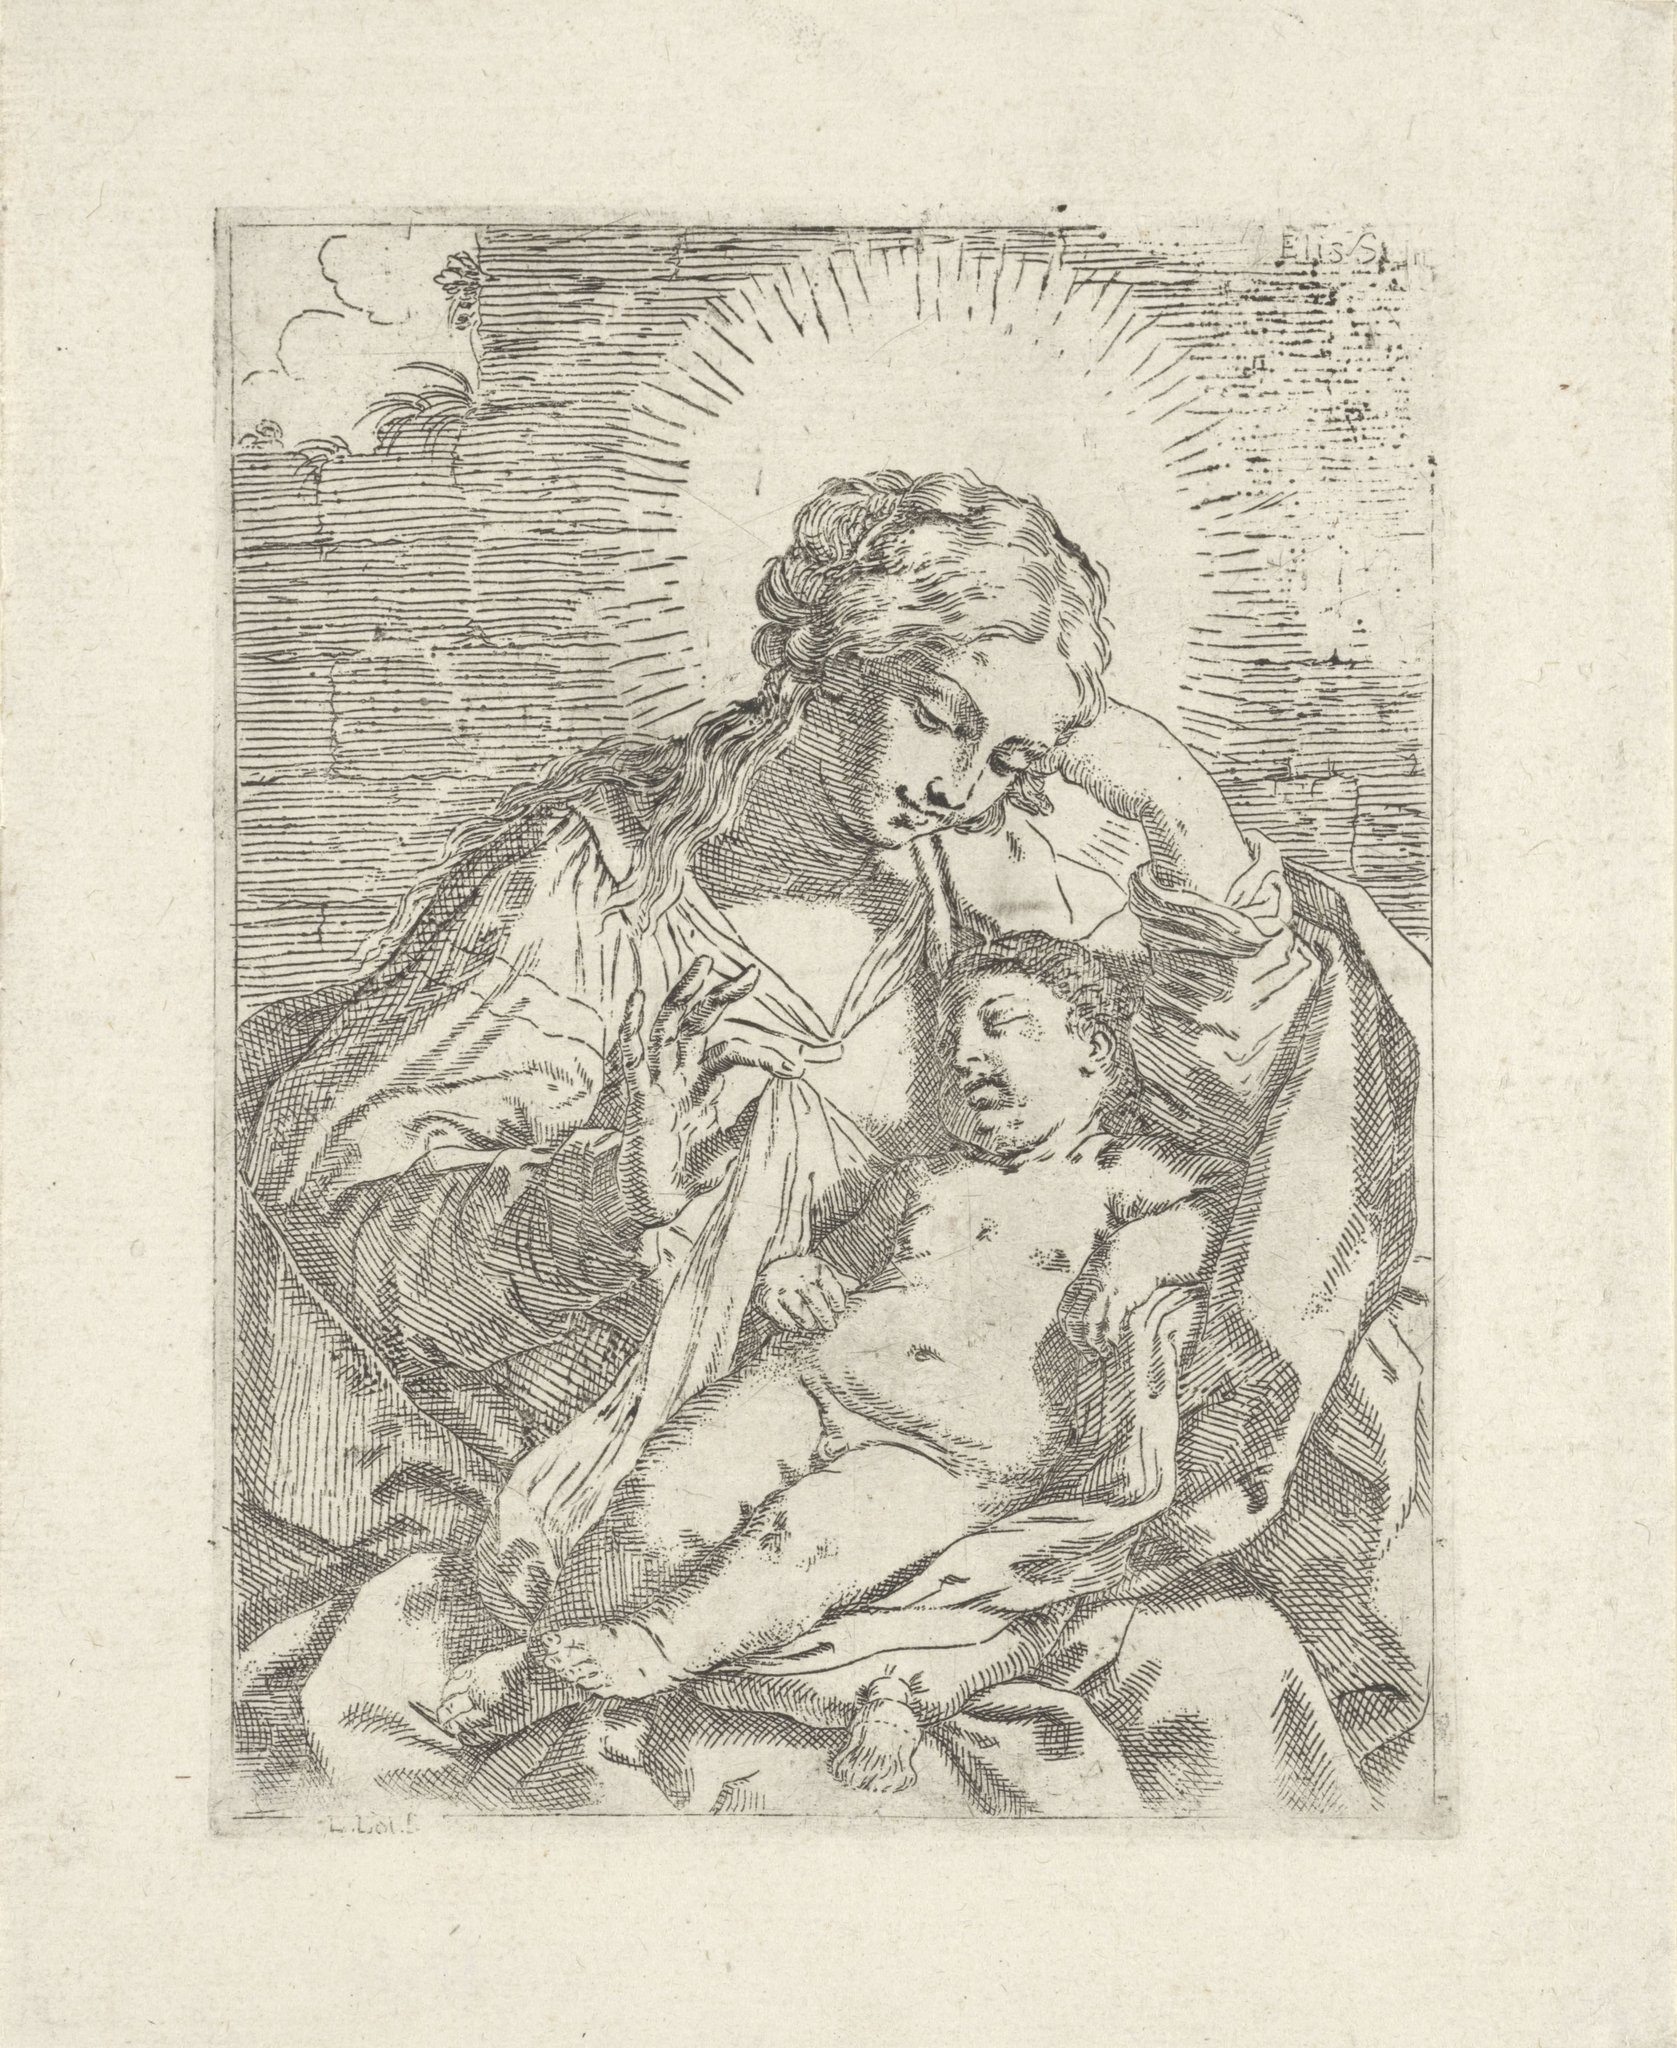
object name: print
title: Maria met Kind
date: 1622-1691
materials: paper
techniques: etching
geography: italy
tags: madonna: i.e. mary with the christ-child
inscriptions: collector's mark: Lugt 2760, collector's mark: Lugt 2228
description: Maria zit met het slapende Christuskind op schoot voor een muur.